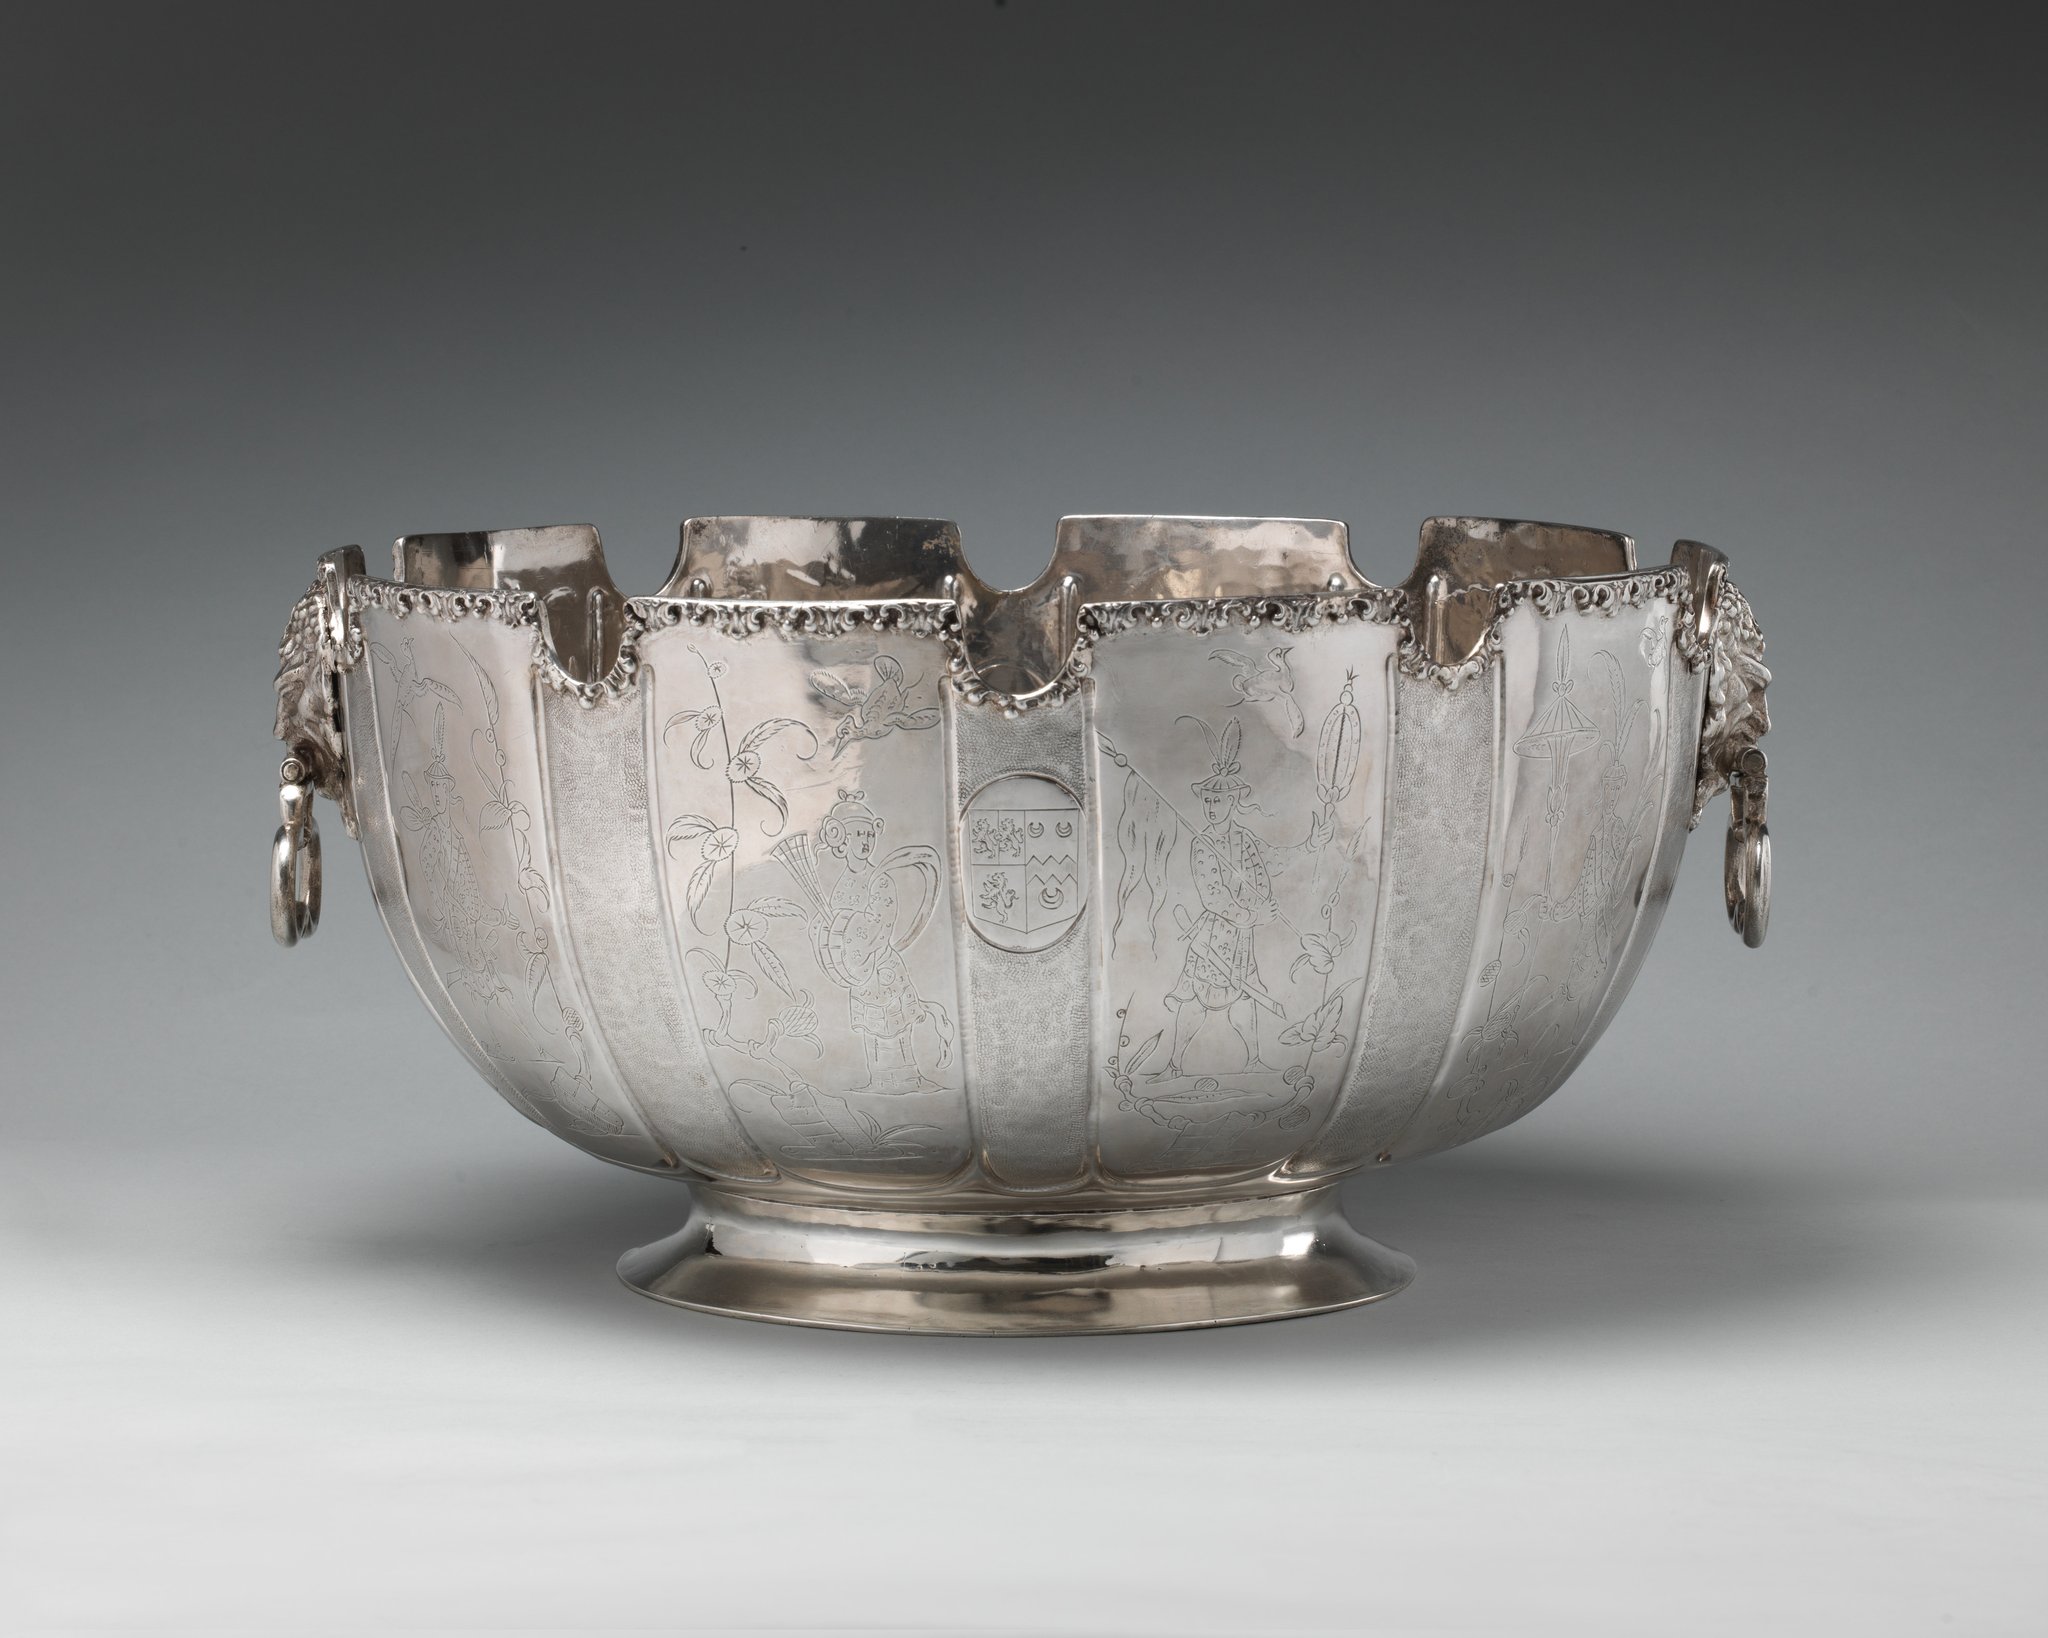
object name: monteith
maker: john spackman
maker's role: maker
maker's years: 1680-1688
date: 1686-1687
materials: silver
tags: men,flowers,coat of arms